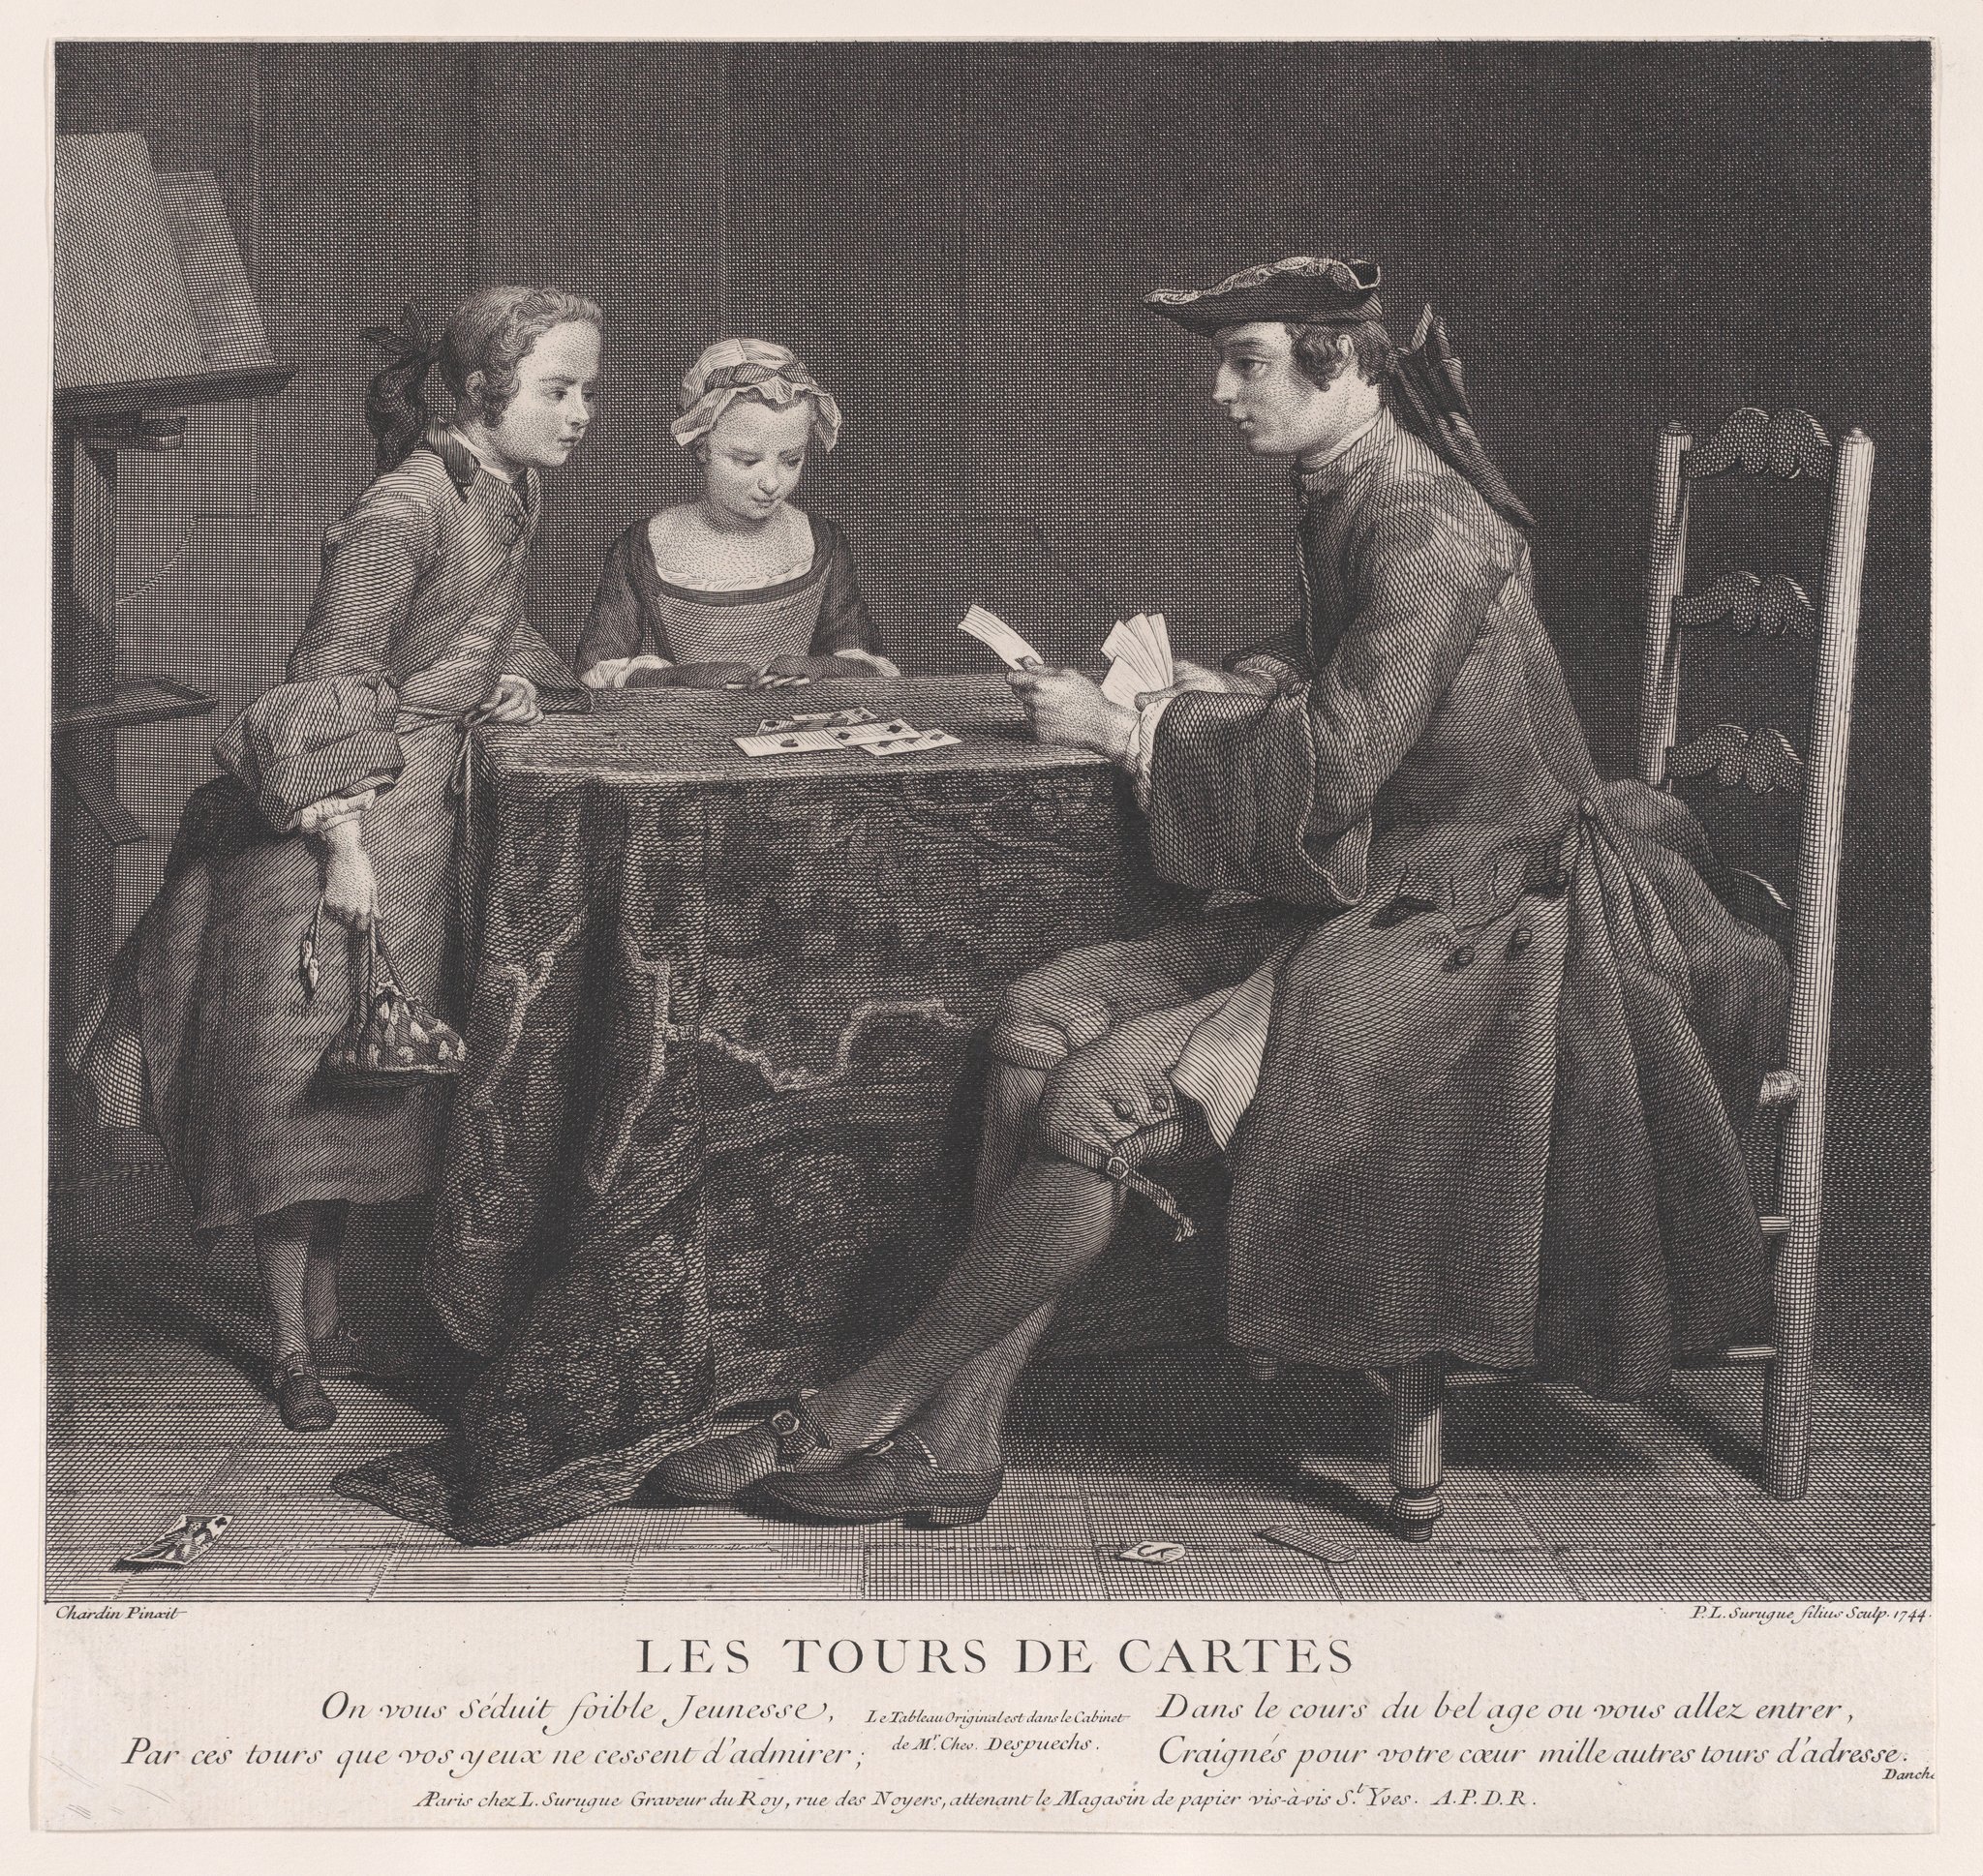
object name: print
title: Card Tricks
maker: pierre louis surugue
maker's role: artist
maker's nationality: french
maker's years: 1716-1772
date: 1744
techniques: engraving, etching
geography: paris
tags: boys,girls,men,playing cards,tables